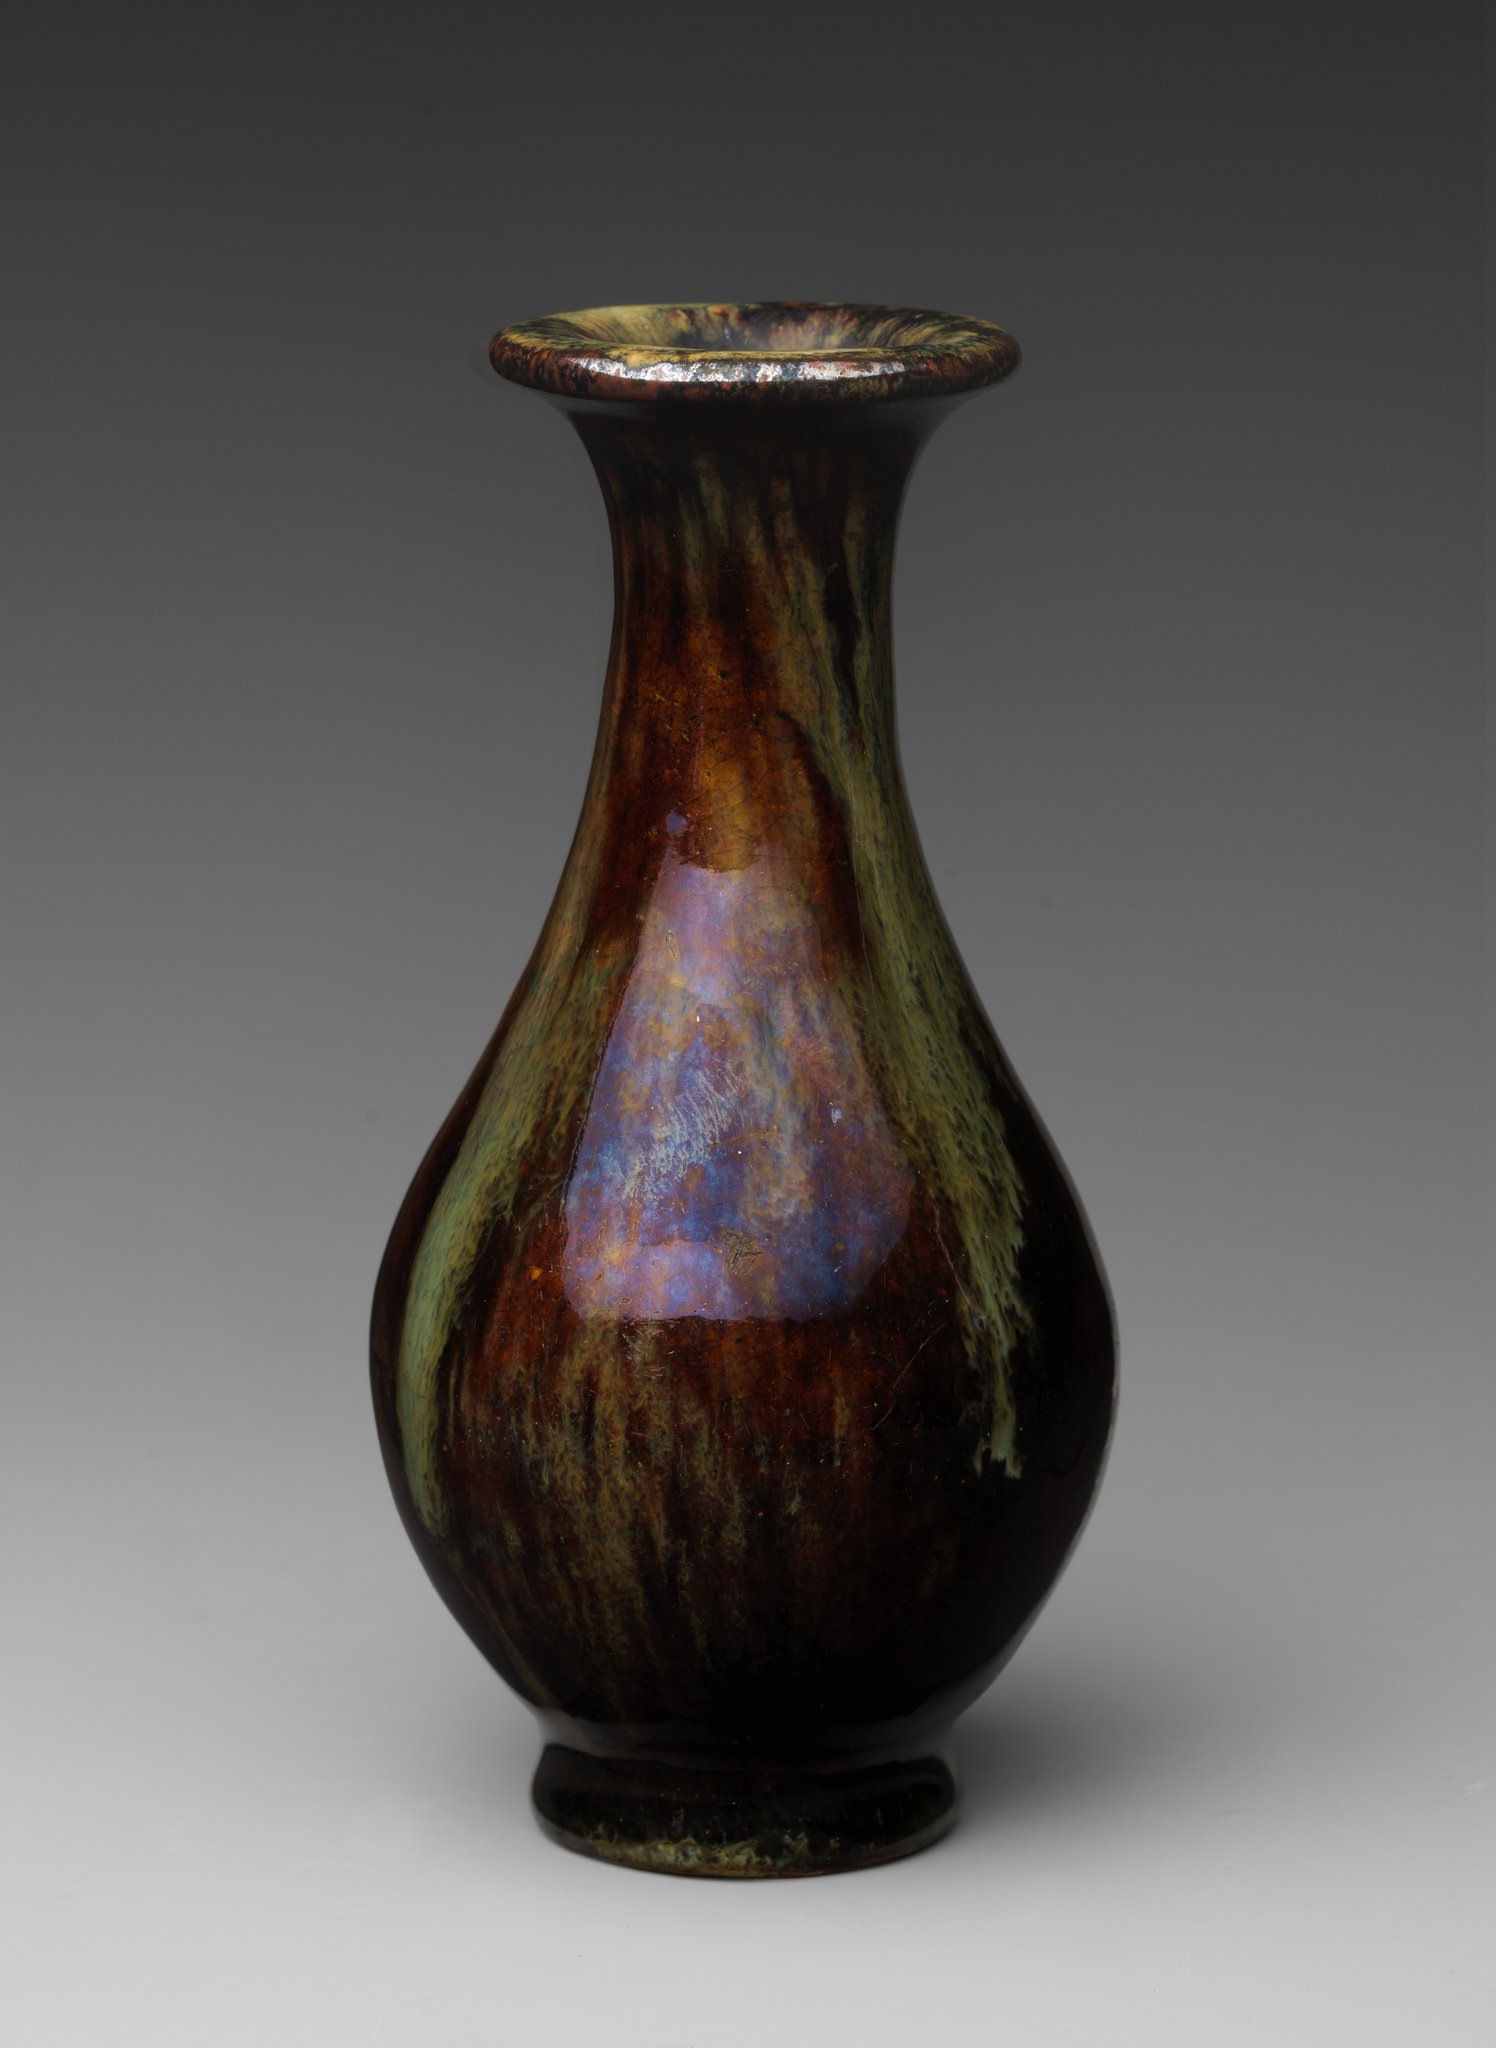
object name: vase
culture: japanese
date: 1601-1700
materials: clay, glaze